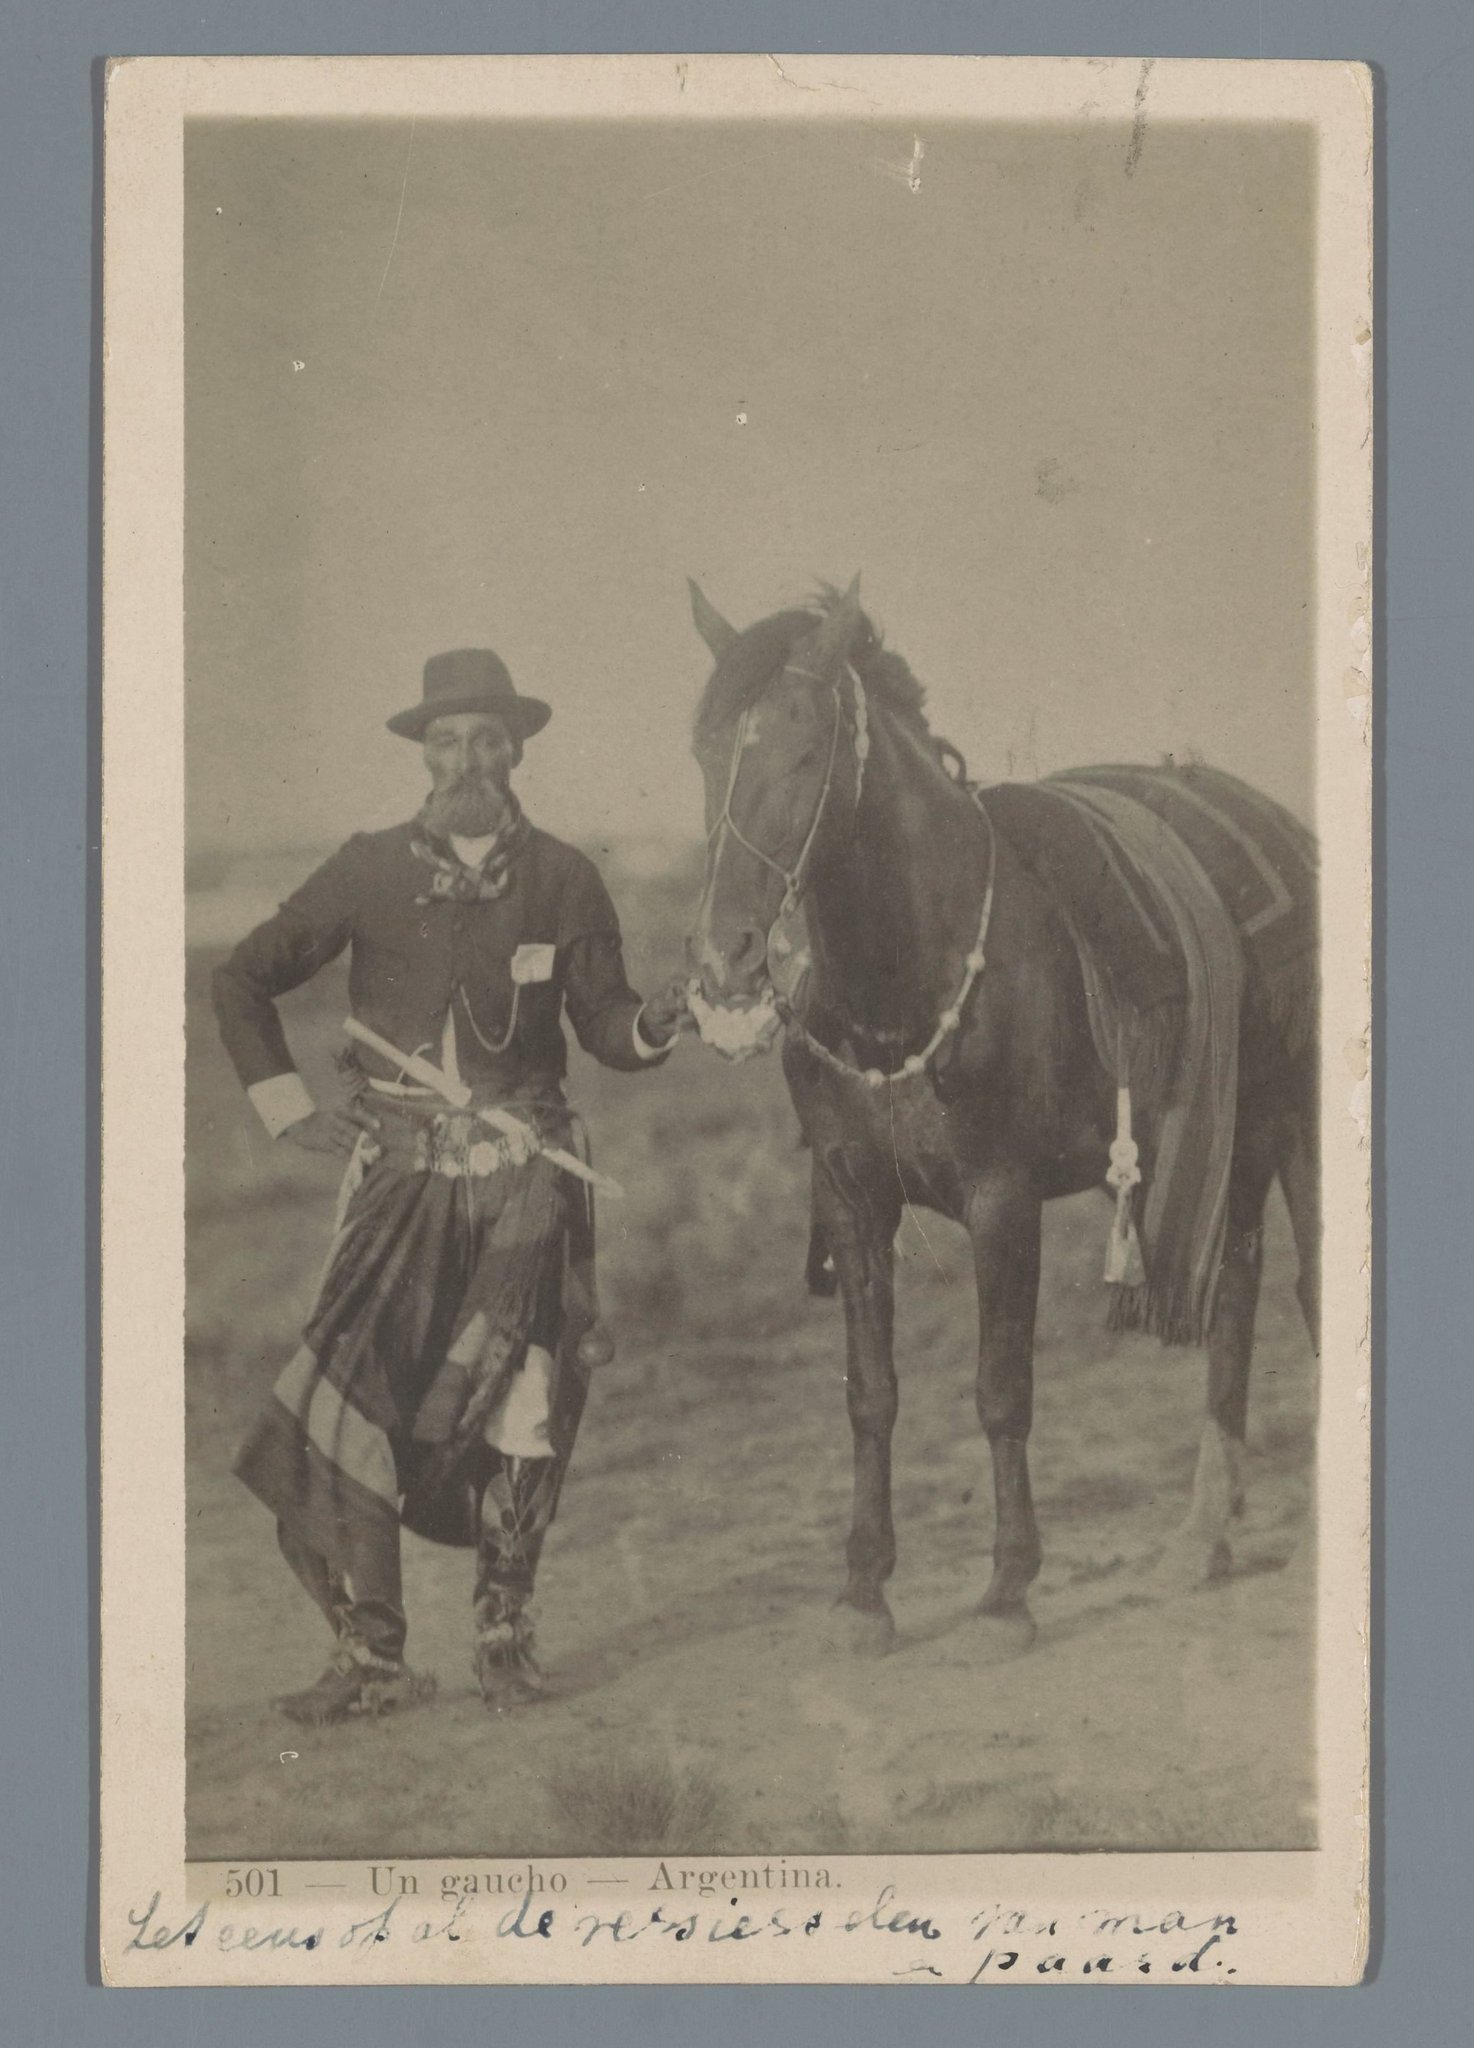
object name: ansichtkaart, prentbriefkaart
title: Portret van een gaucho met een paard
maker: Anonymous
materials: photographic support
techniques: gelatin silver print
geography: argentinië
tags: cattle driving, cattle driver, horse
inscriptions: number: ‘501’, inscription: ‘Lieve allemaal (...) Holanda’, inscription: ‘let eens (...) paard.’, inscription: ‘Buenos Aires-13 Dic 6 1928’